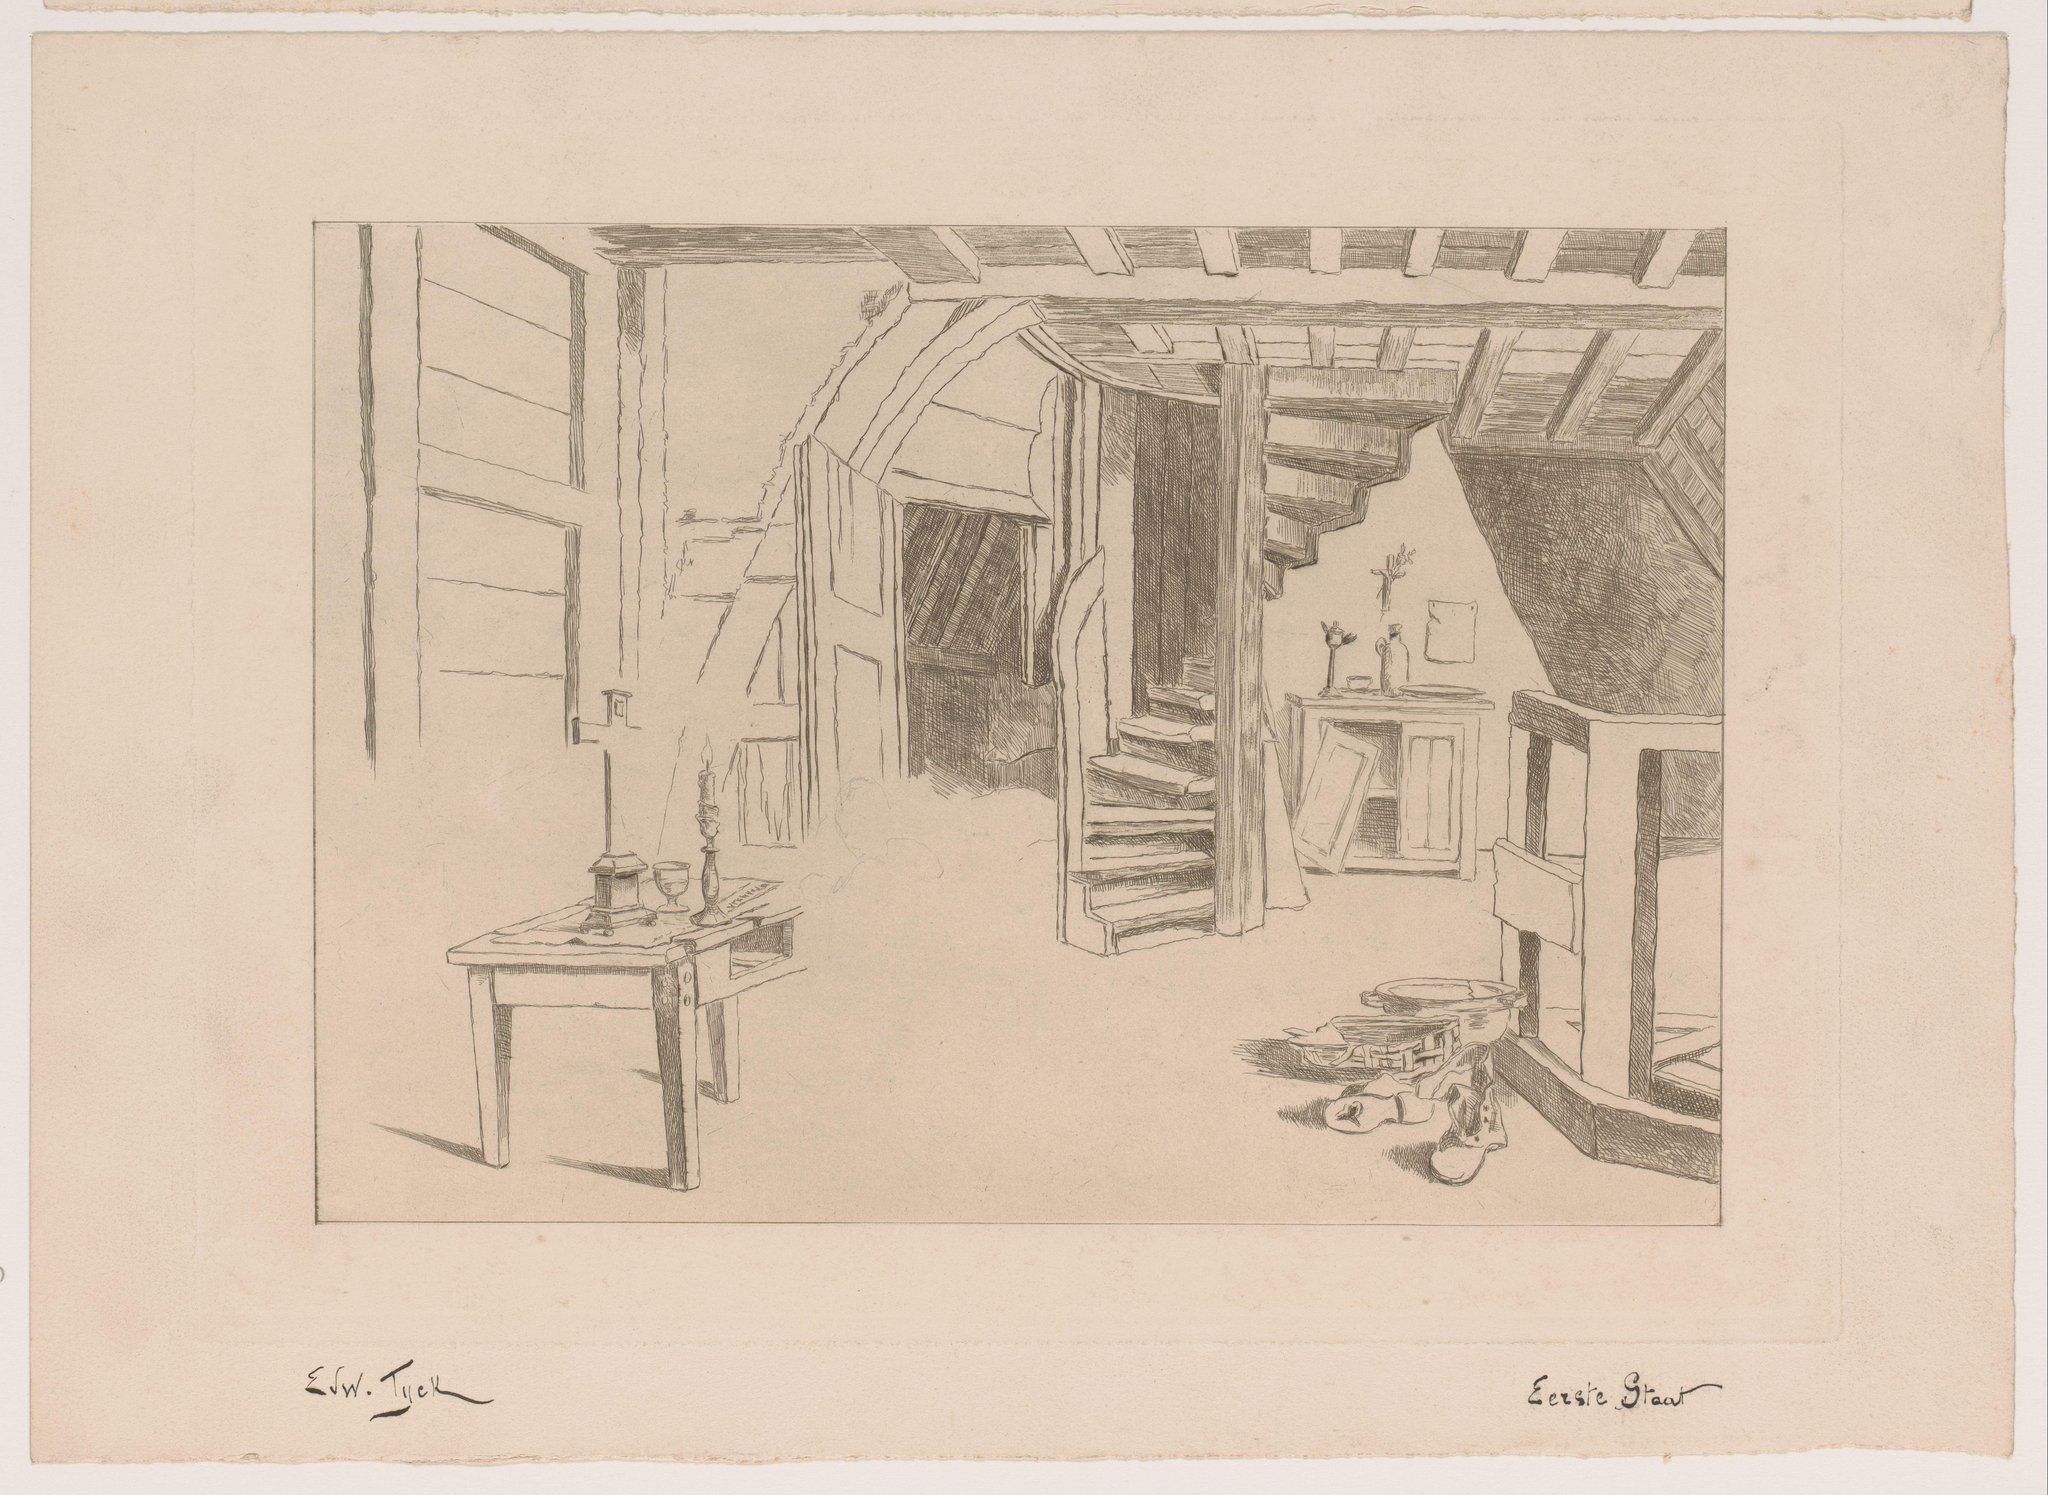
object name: print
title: Zolderinterieur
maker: edouard tyck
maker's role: print maker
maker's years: 1847-1922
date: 1891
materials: paper, pencil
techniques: drawing, drypoint, etching, intaglio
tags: attic, loft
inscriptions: annotation: ‘Eerste Staat’, collector's mark: Lugt 2228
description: Interieur van de in 1882 afgebroken zolder in het huis Plantin-Moretus aan de Vrijdagmarkt in Antwerpen.